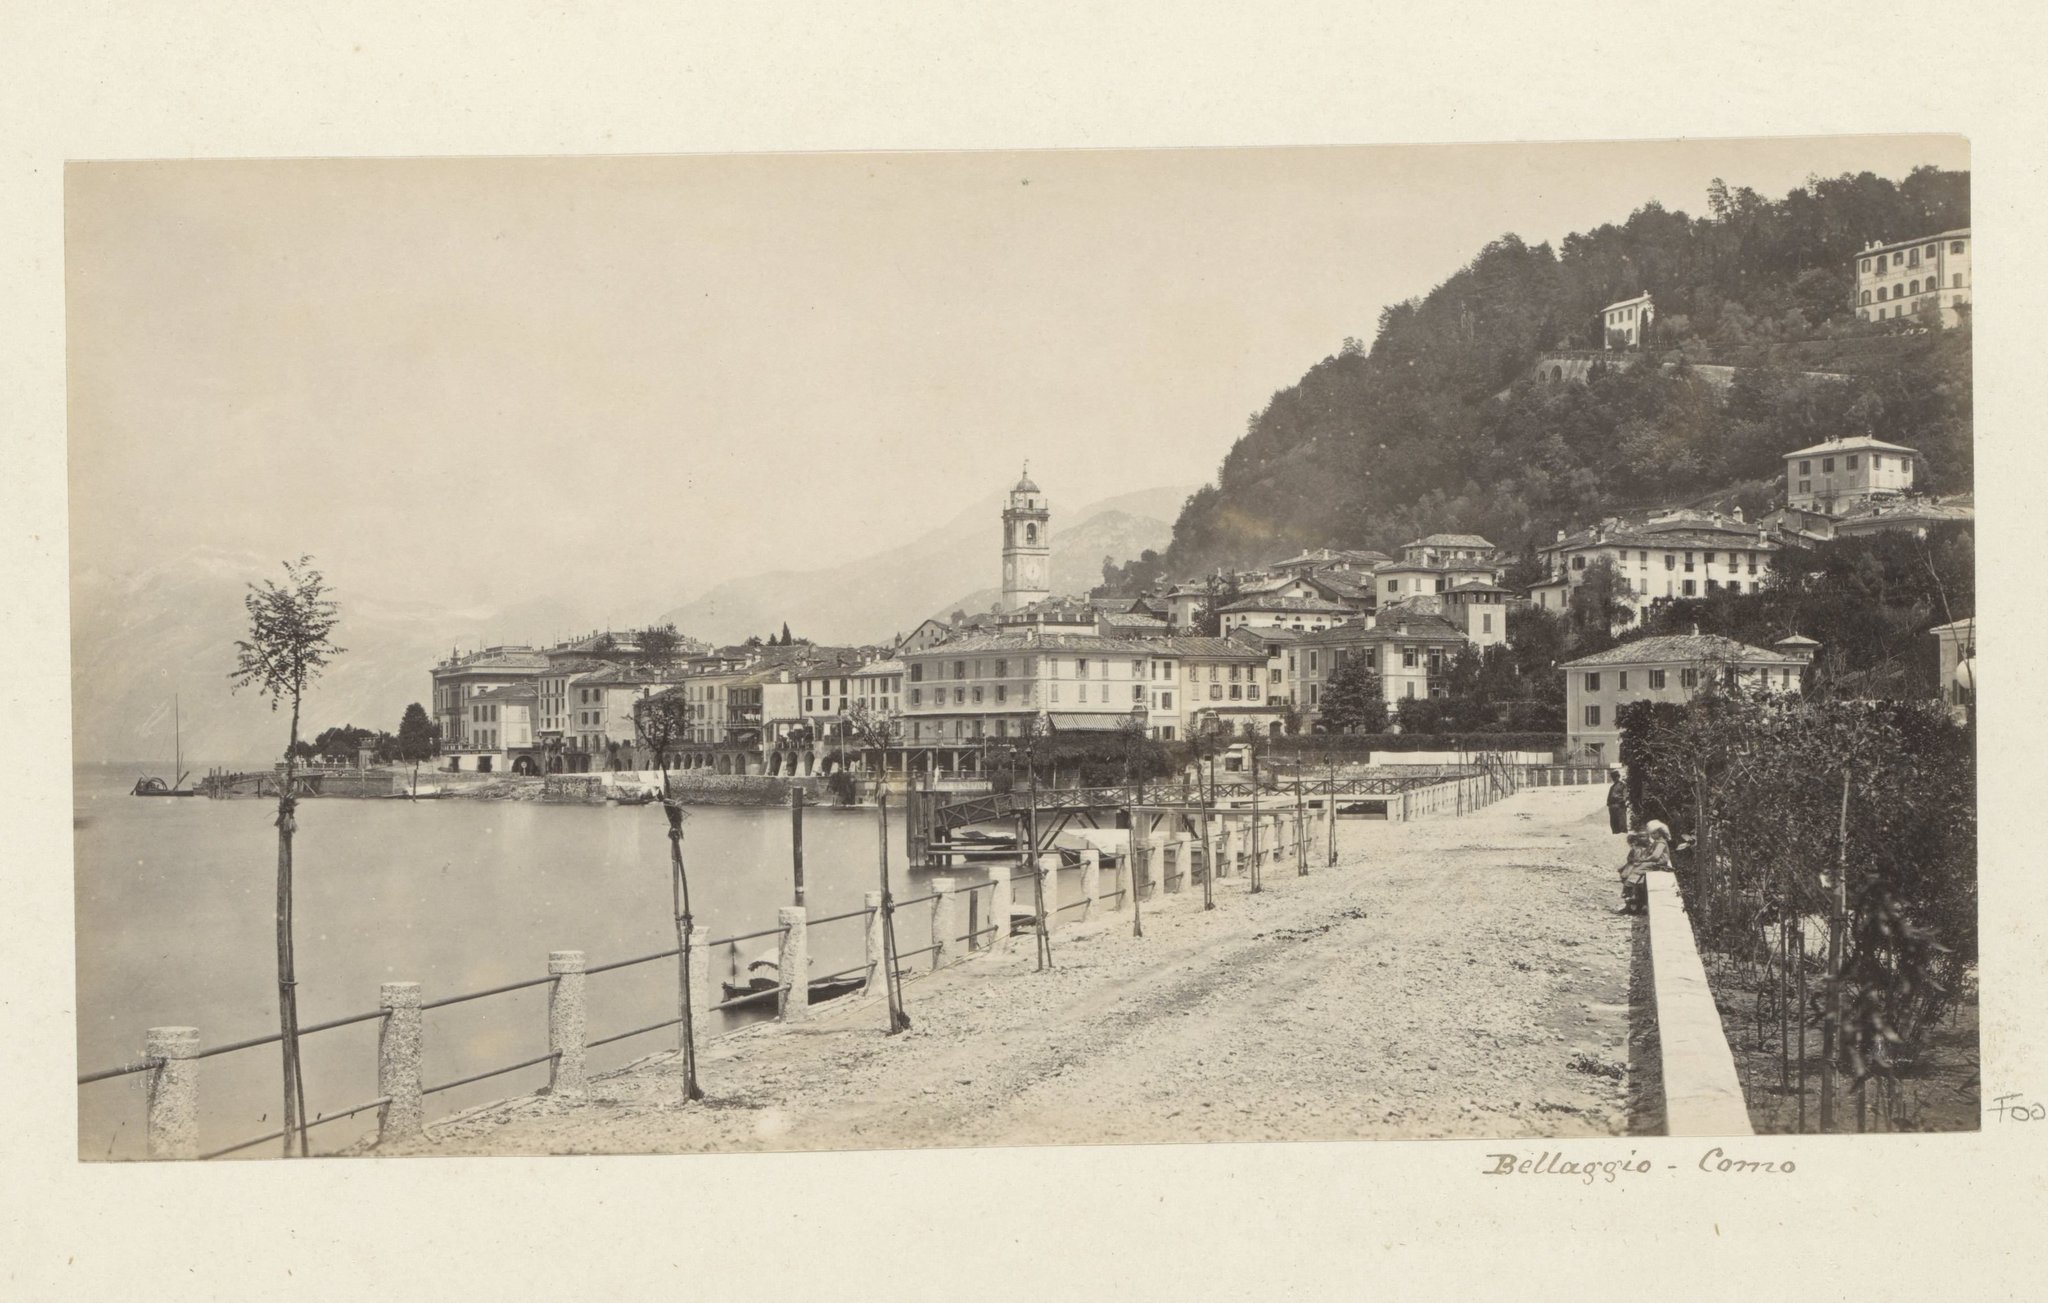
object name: photograph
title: Bellaggio - Como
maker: francis frith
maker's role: publisher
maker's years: 1822-1898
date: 1859-1898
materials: paper, photographic support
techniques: albumen print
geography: bellagio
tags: prospect of village, silhouette of village, avenue, boulevard, promenade, esplanade (+ city(-scape) with figures, staffage)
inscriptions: name: ‘Frith Series’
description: Onderdeel van Reisalbum met foto's van Zwitserland, Oostenrijk, Italië en Duitsland.